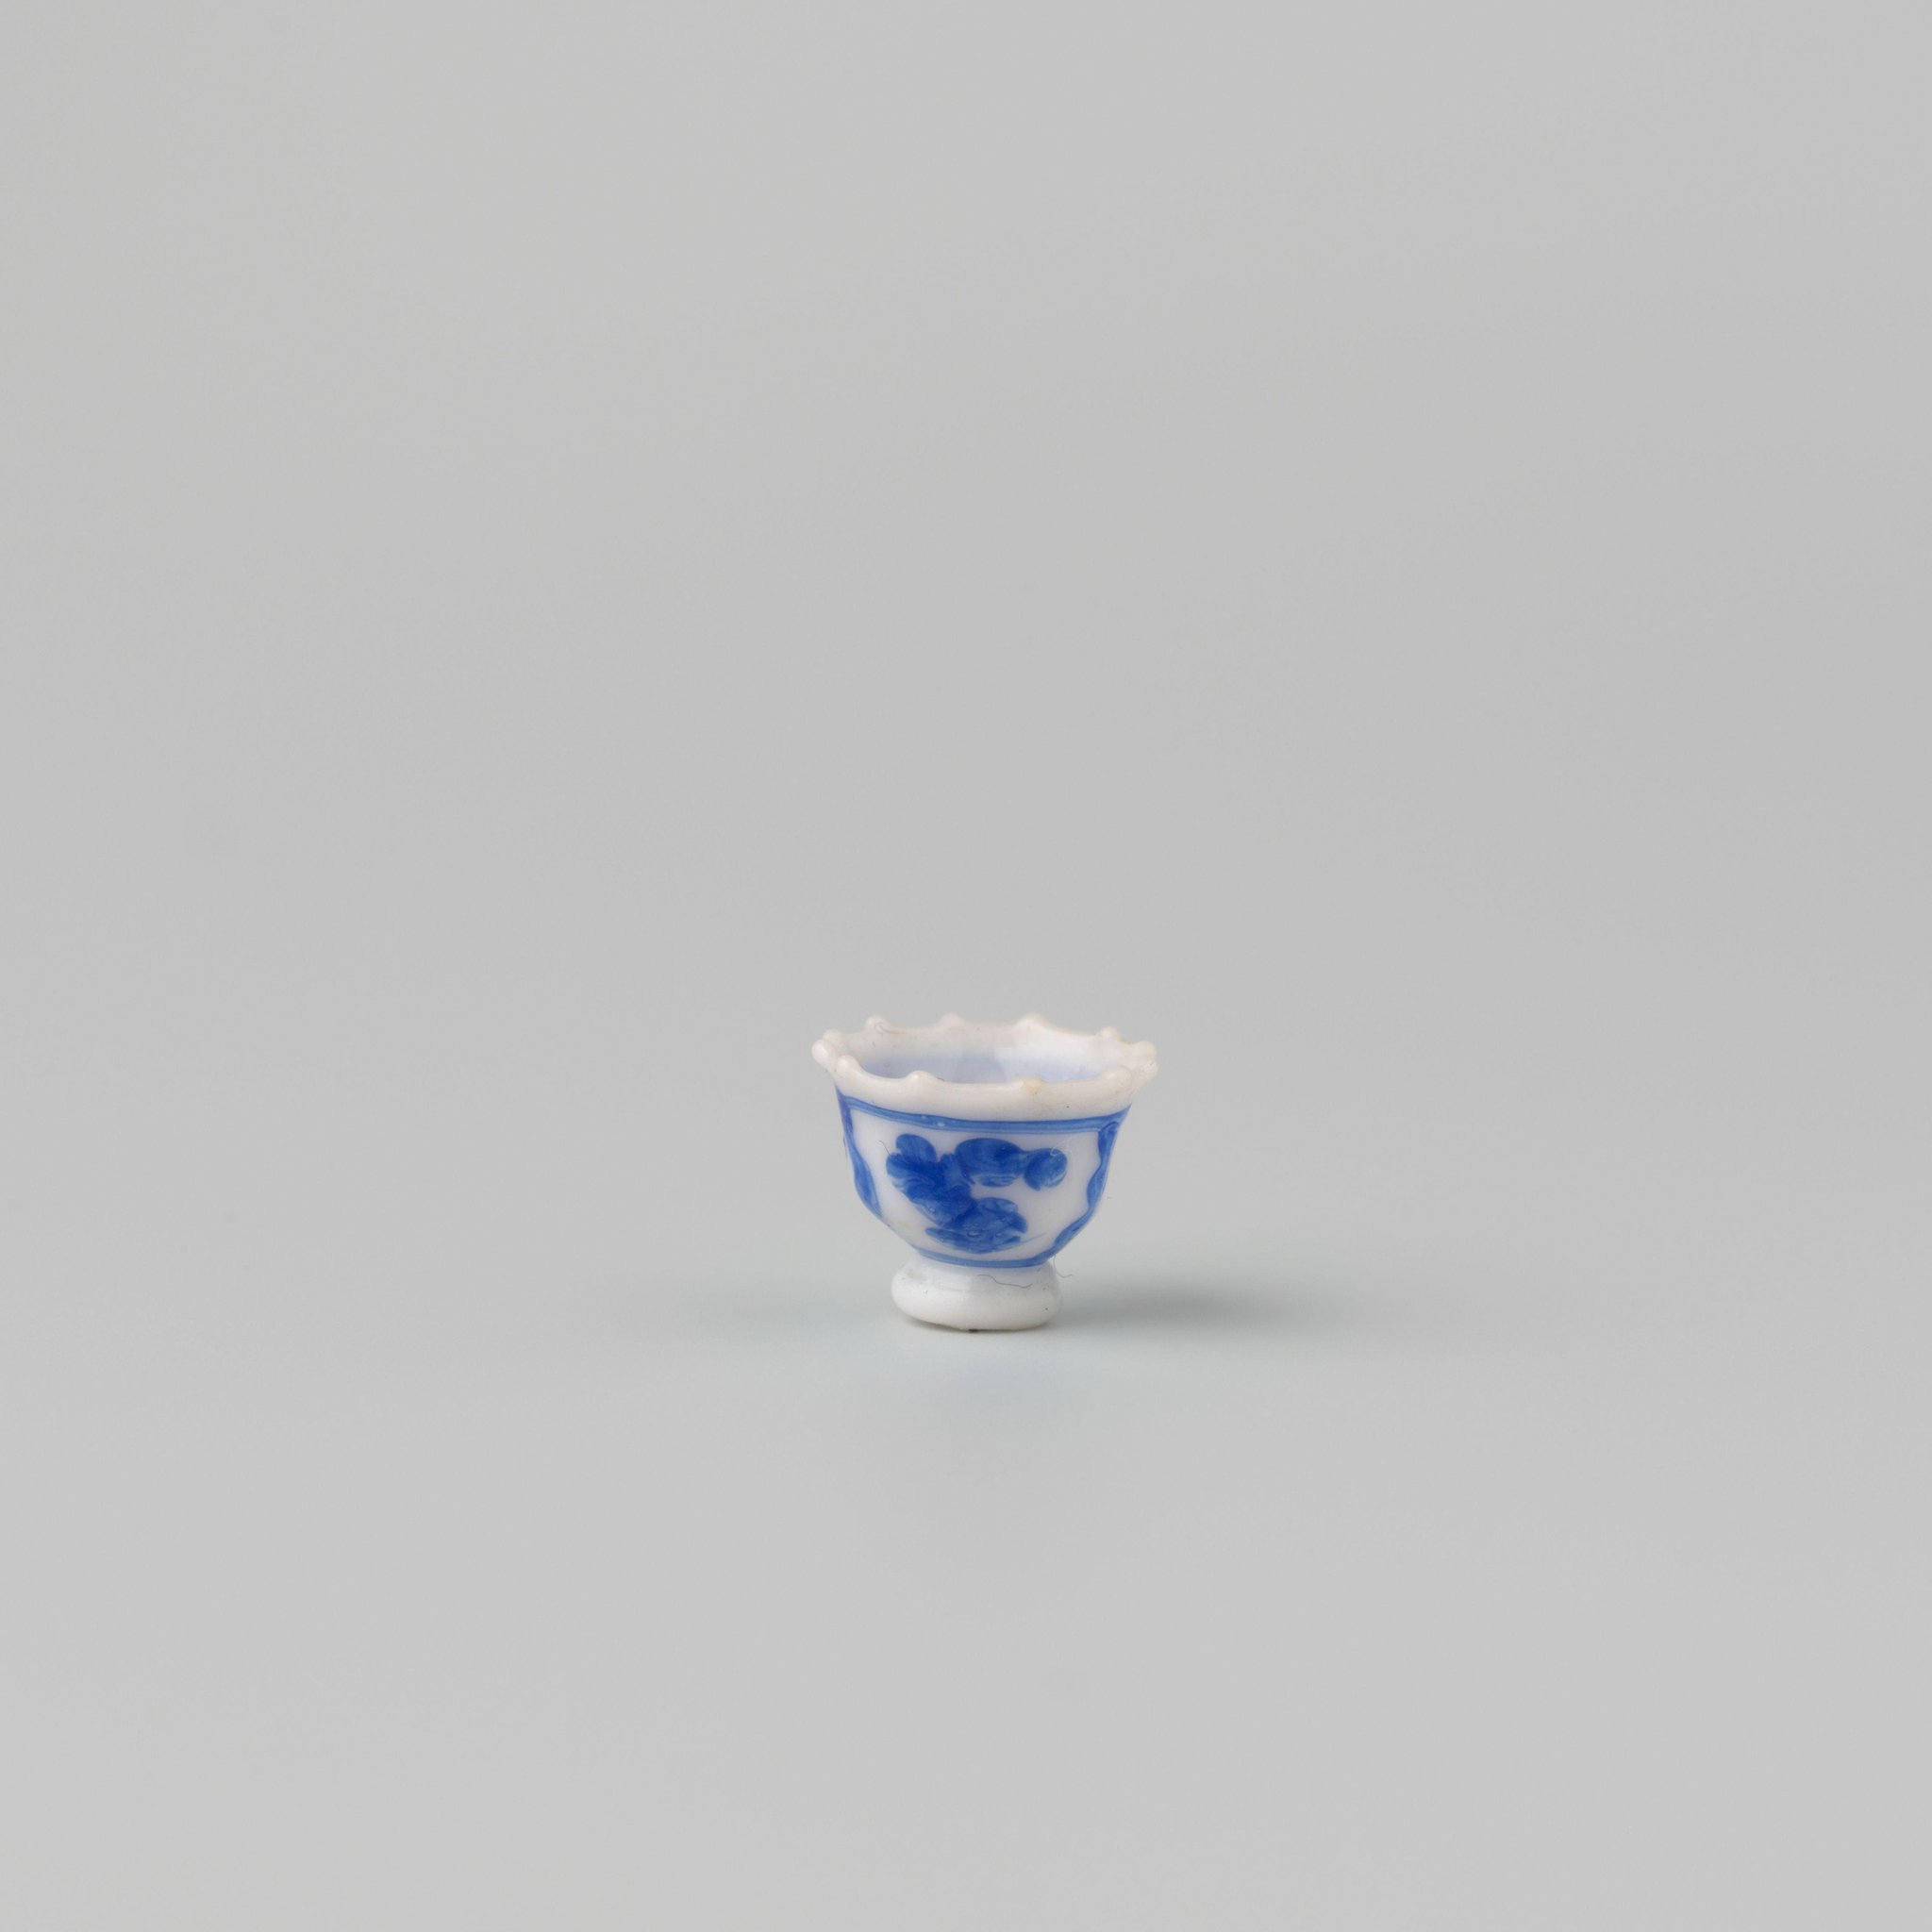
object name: cup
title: Theekopje van melkglas met blauwe emailverf beschildering, imitatie Chinees porselein met 'bloem' decoratie in vakken; model op los aangebrachte standring en met puntrand.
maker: Anonymous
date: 1675-1710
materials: glass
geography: amsterdam